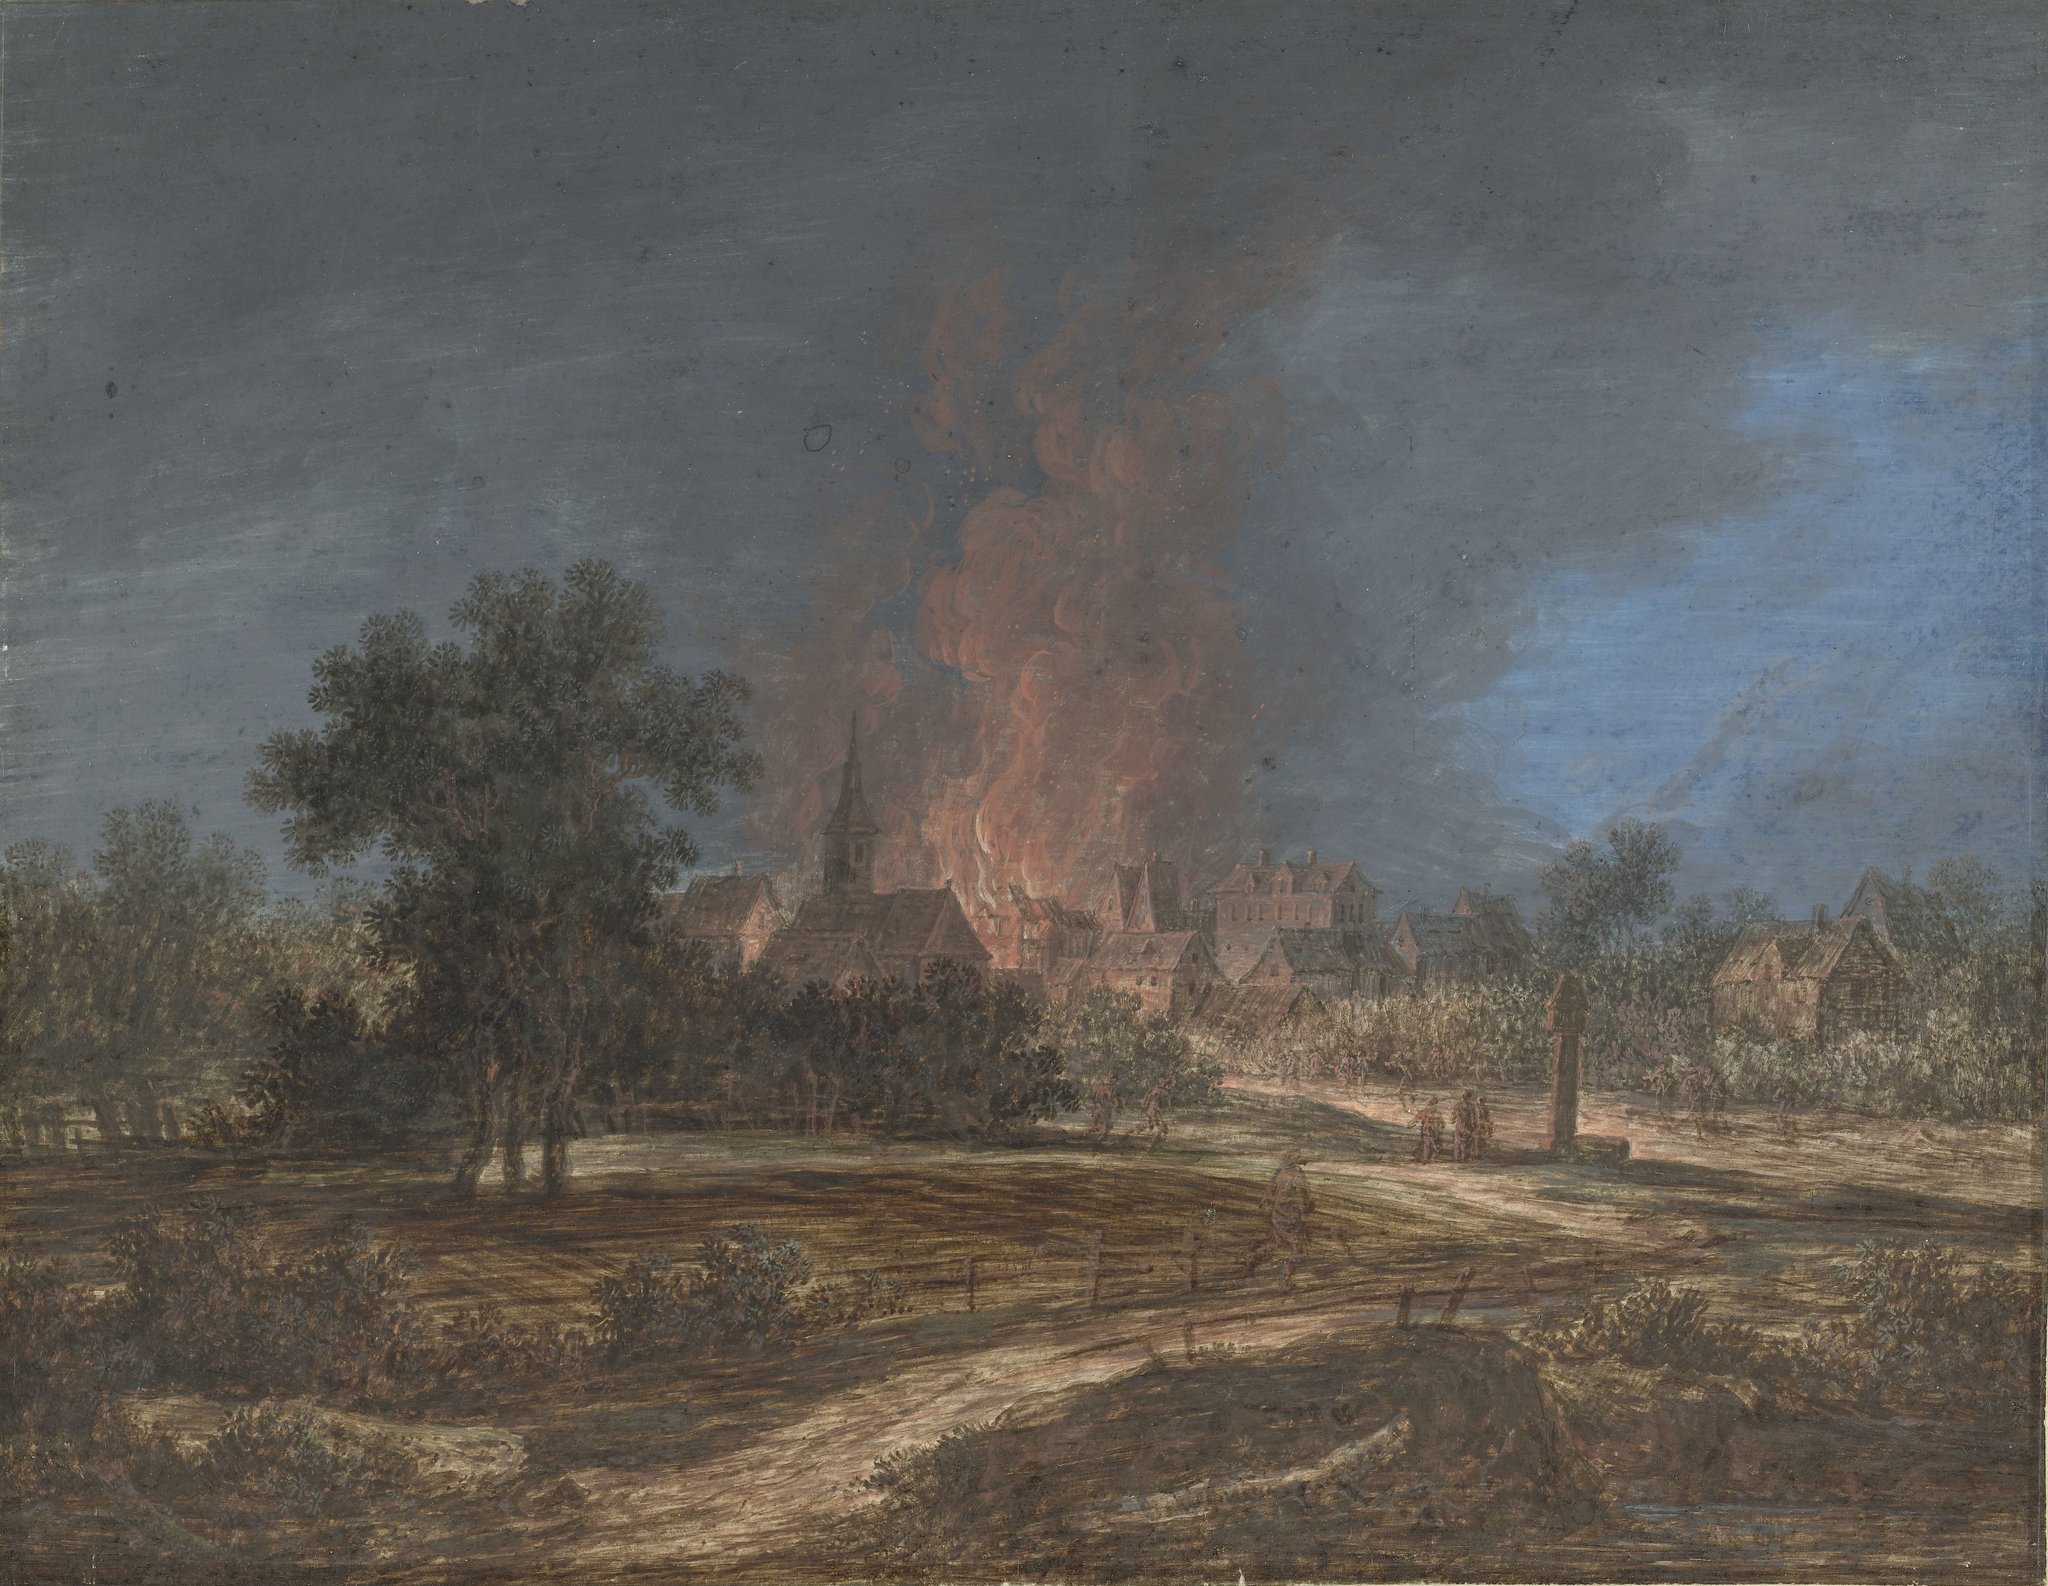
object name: drawing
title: Brand in een dorp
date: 1677-1719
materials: paint, parchment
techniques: brush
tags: on fire, ablaze